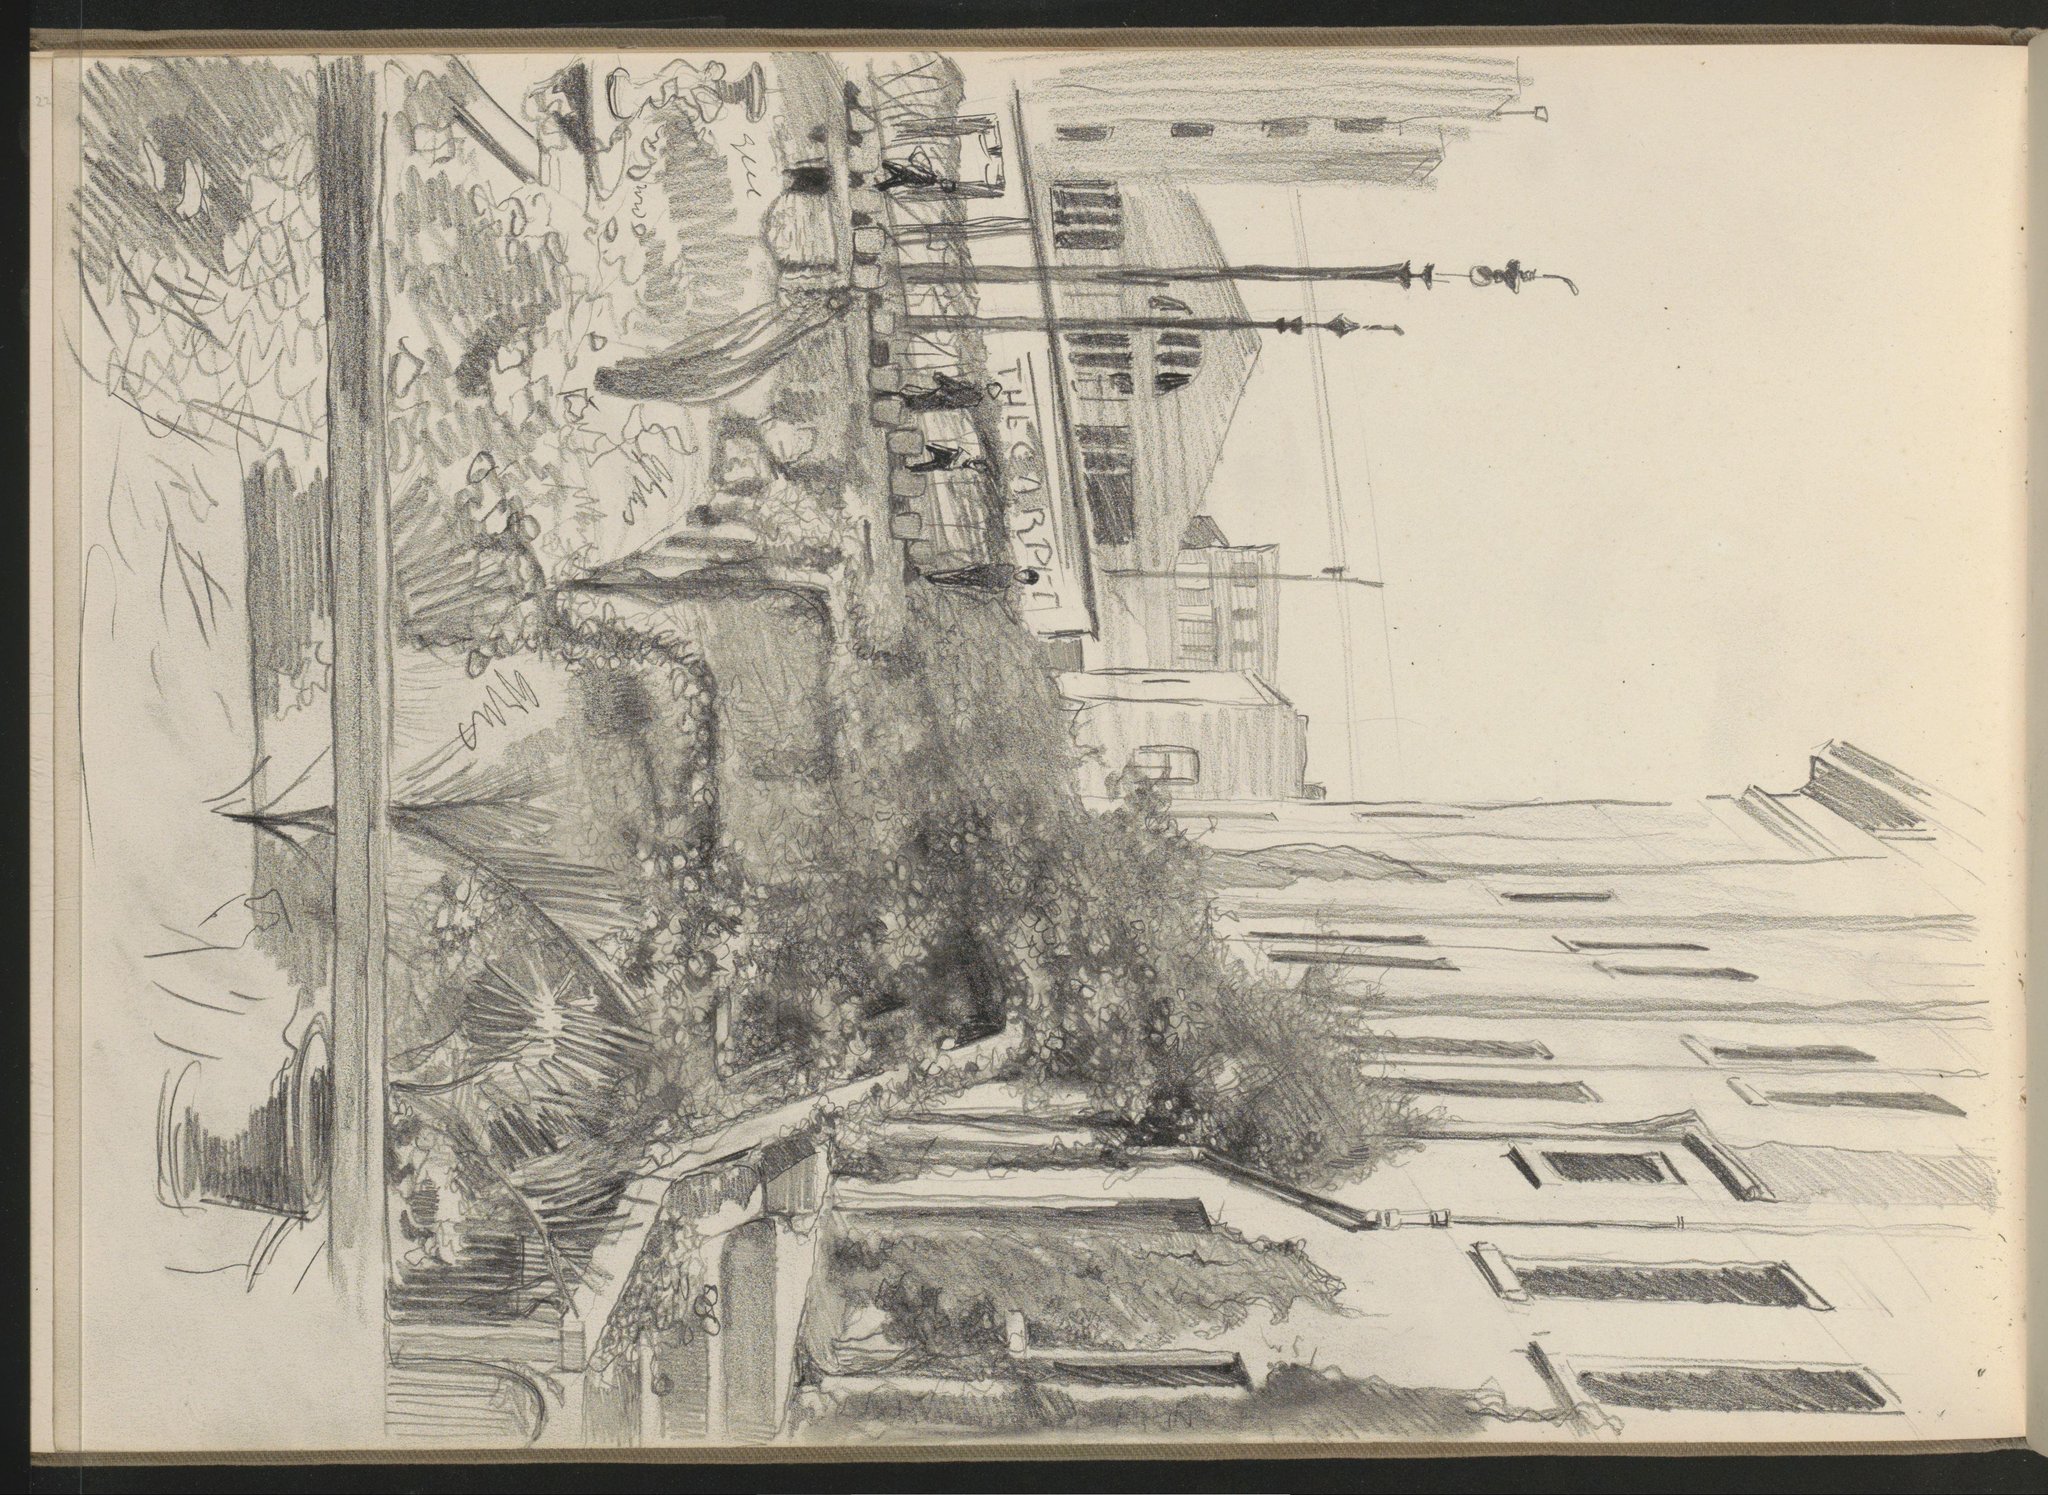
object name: sketchbook leaf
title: Stadsgezicht met een tuin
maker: willem witsen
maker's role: draughtsman, painter, print maker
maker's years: 1860-1923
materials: paper, pencil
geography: san francisco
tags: city-view, and landscape with man-made constructions, garden, civic architecture; edifices; dwellings, venice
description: Pagina 32 uit een schetsboek met 32 bladen.